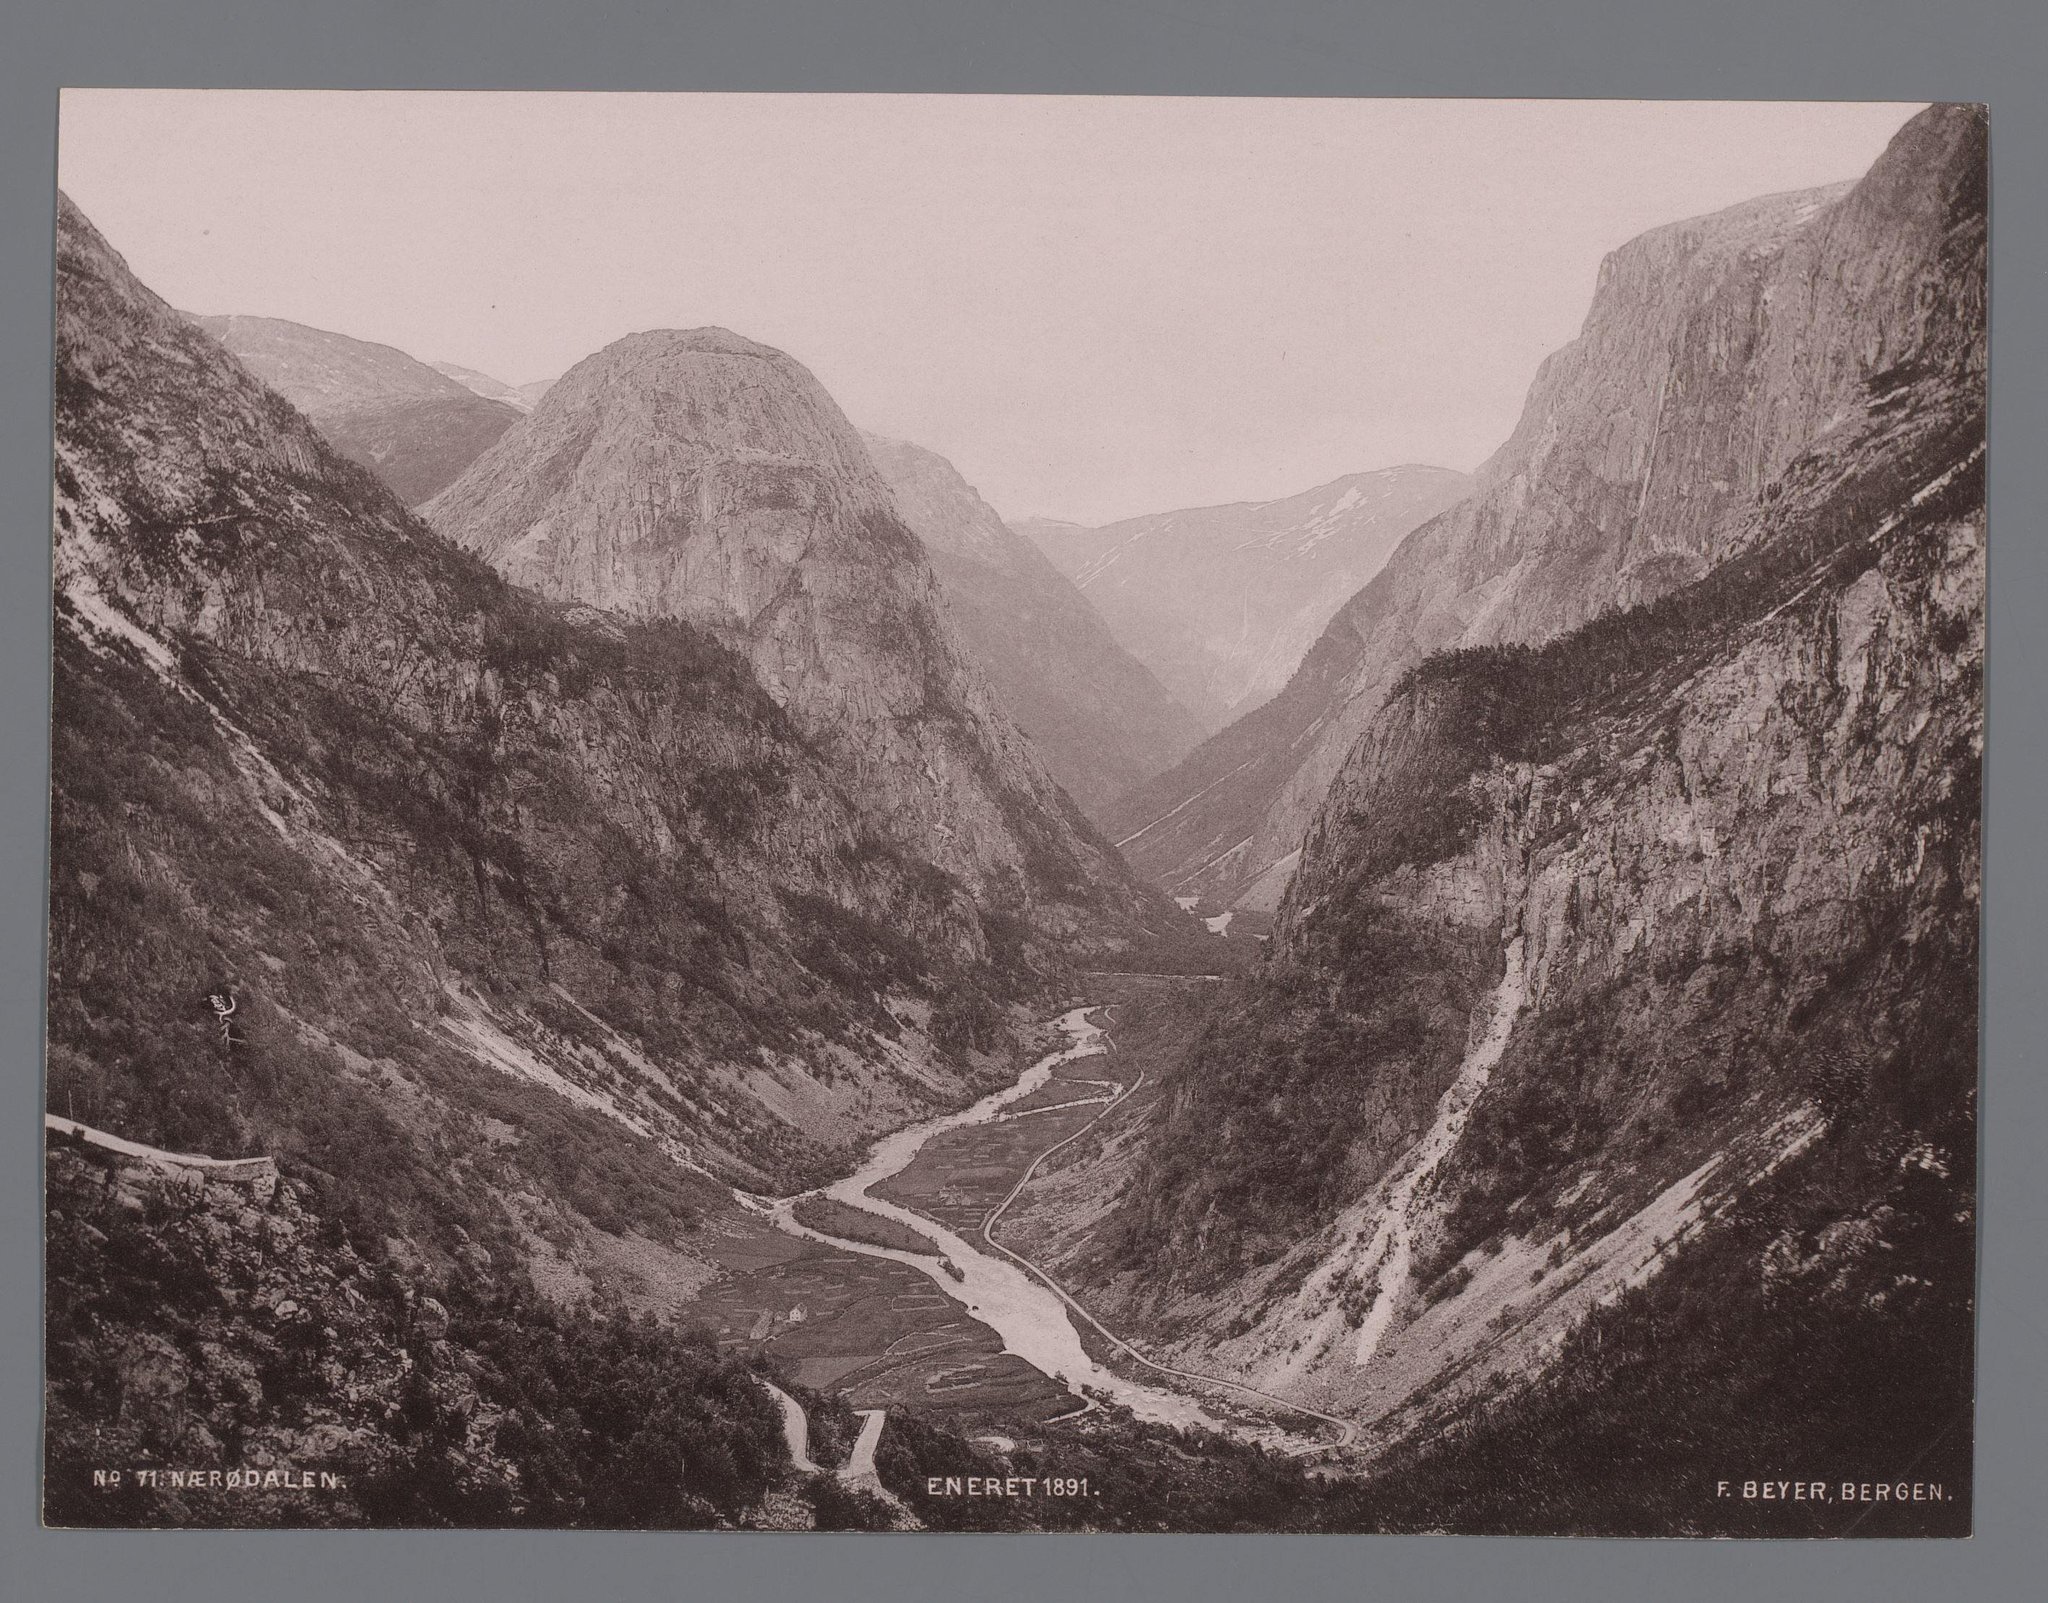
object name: photomechanical print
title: Gezicht op Nærøydalen in Aurland, Noorwegen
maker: Anonymous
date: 1891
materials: paper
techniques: photograph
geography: nærøydalen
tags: dale, valley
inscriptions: number: ‘No 71.’, inscription: ‘ENERET’